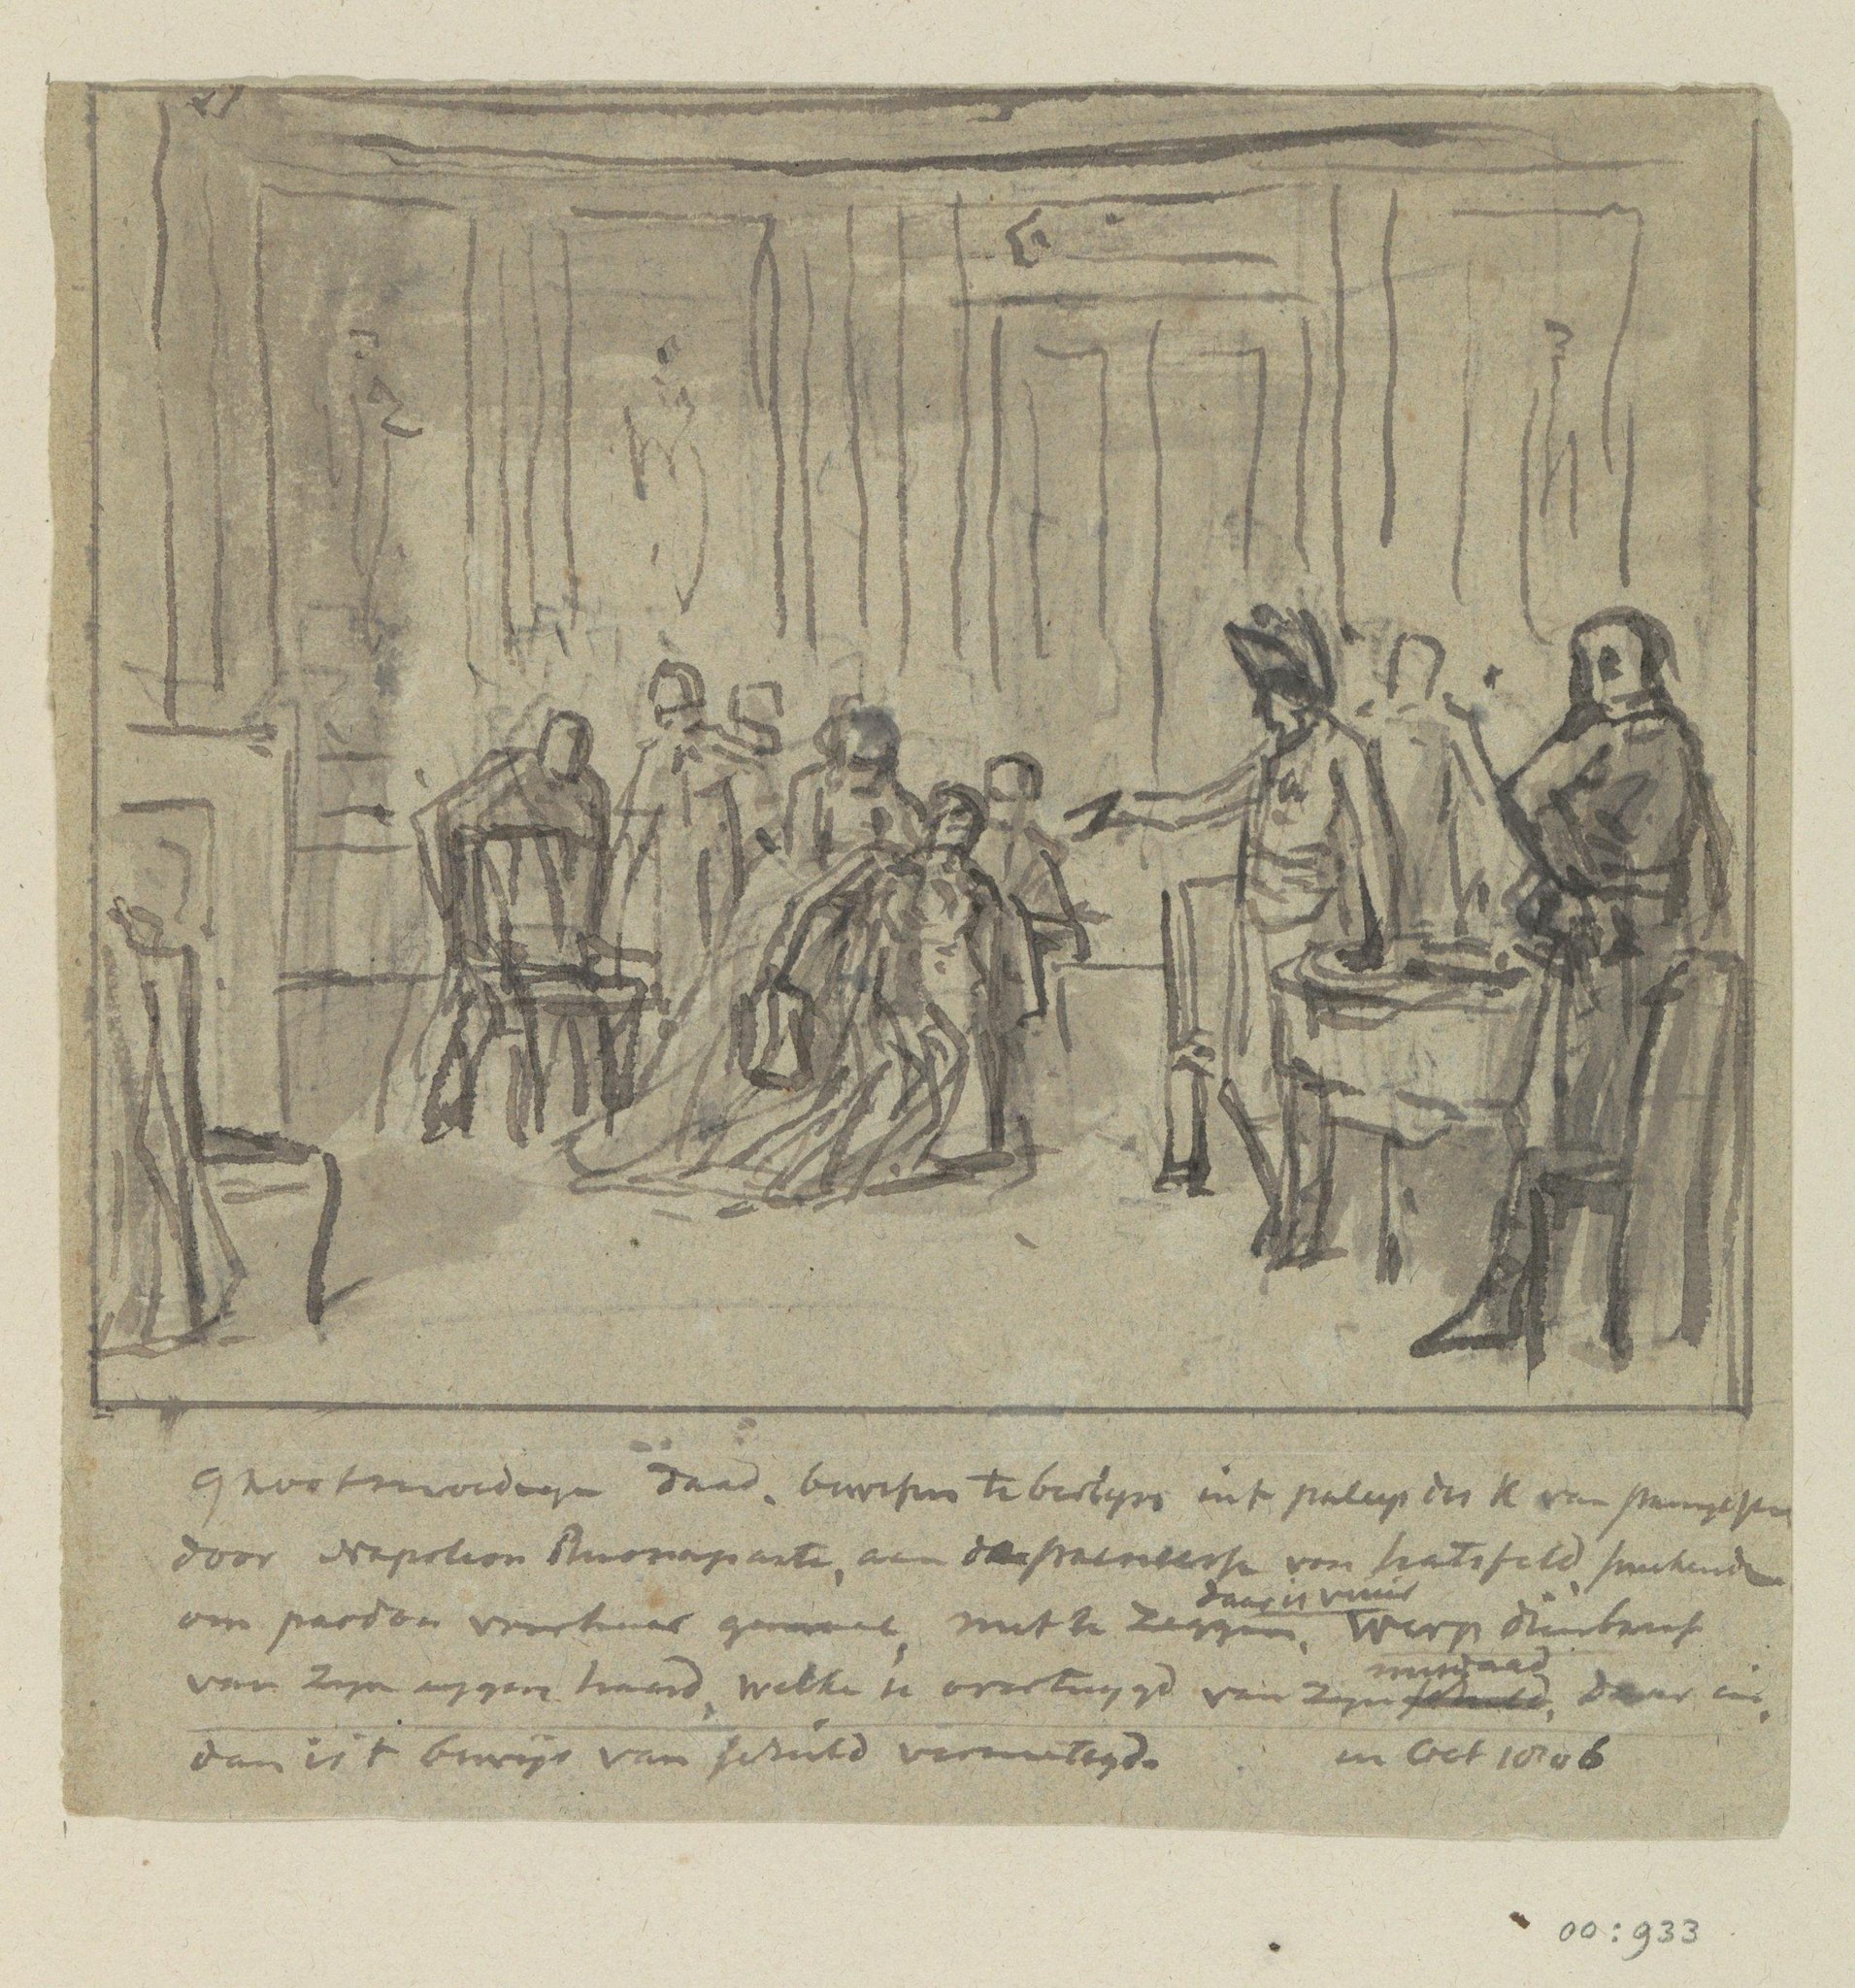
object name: drawing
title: Prinses van Hatzfeldt smeekt Napoleon Bonaparte het leven van haar man te sparen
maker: jurriaan andriessen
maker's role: draughtsman, painter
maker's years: 1742-1819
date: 1806-1819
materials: paper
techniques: brush, pen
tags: napoleon i (emperor of the french), historical events and situations; historical persons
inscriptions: inscription: ‘grootmoedigen daad, beweesen te berlijn int paleis des K. van pruisschen/ door Napoleon Bonaparte aan de princesse van Hatsfeld smeekende/ om pardon voor haar gemaal, met te zeggen daar is vuur werp den brief/ van zijn eijgen hand, welke is overtuijgd van den misdaad, daar in/ dan is 't bewijs van schuld vernietigd. in Oct 1806’